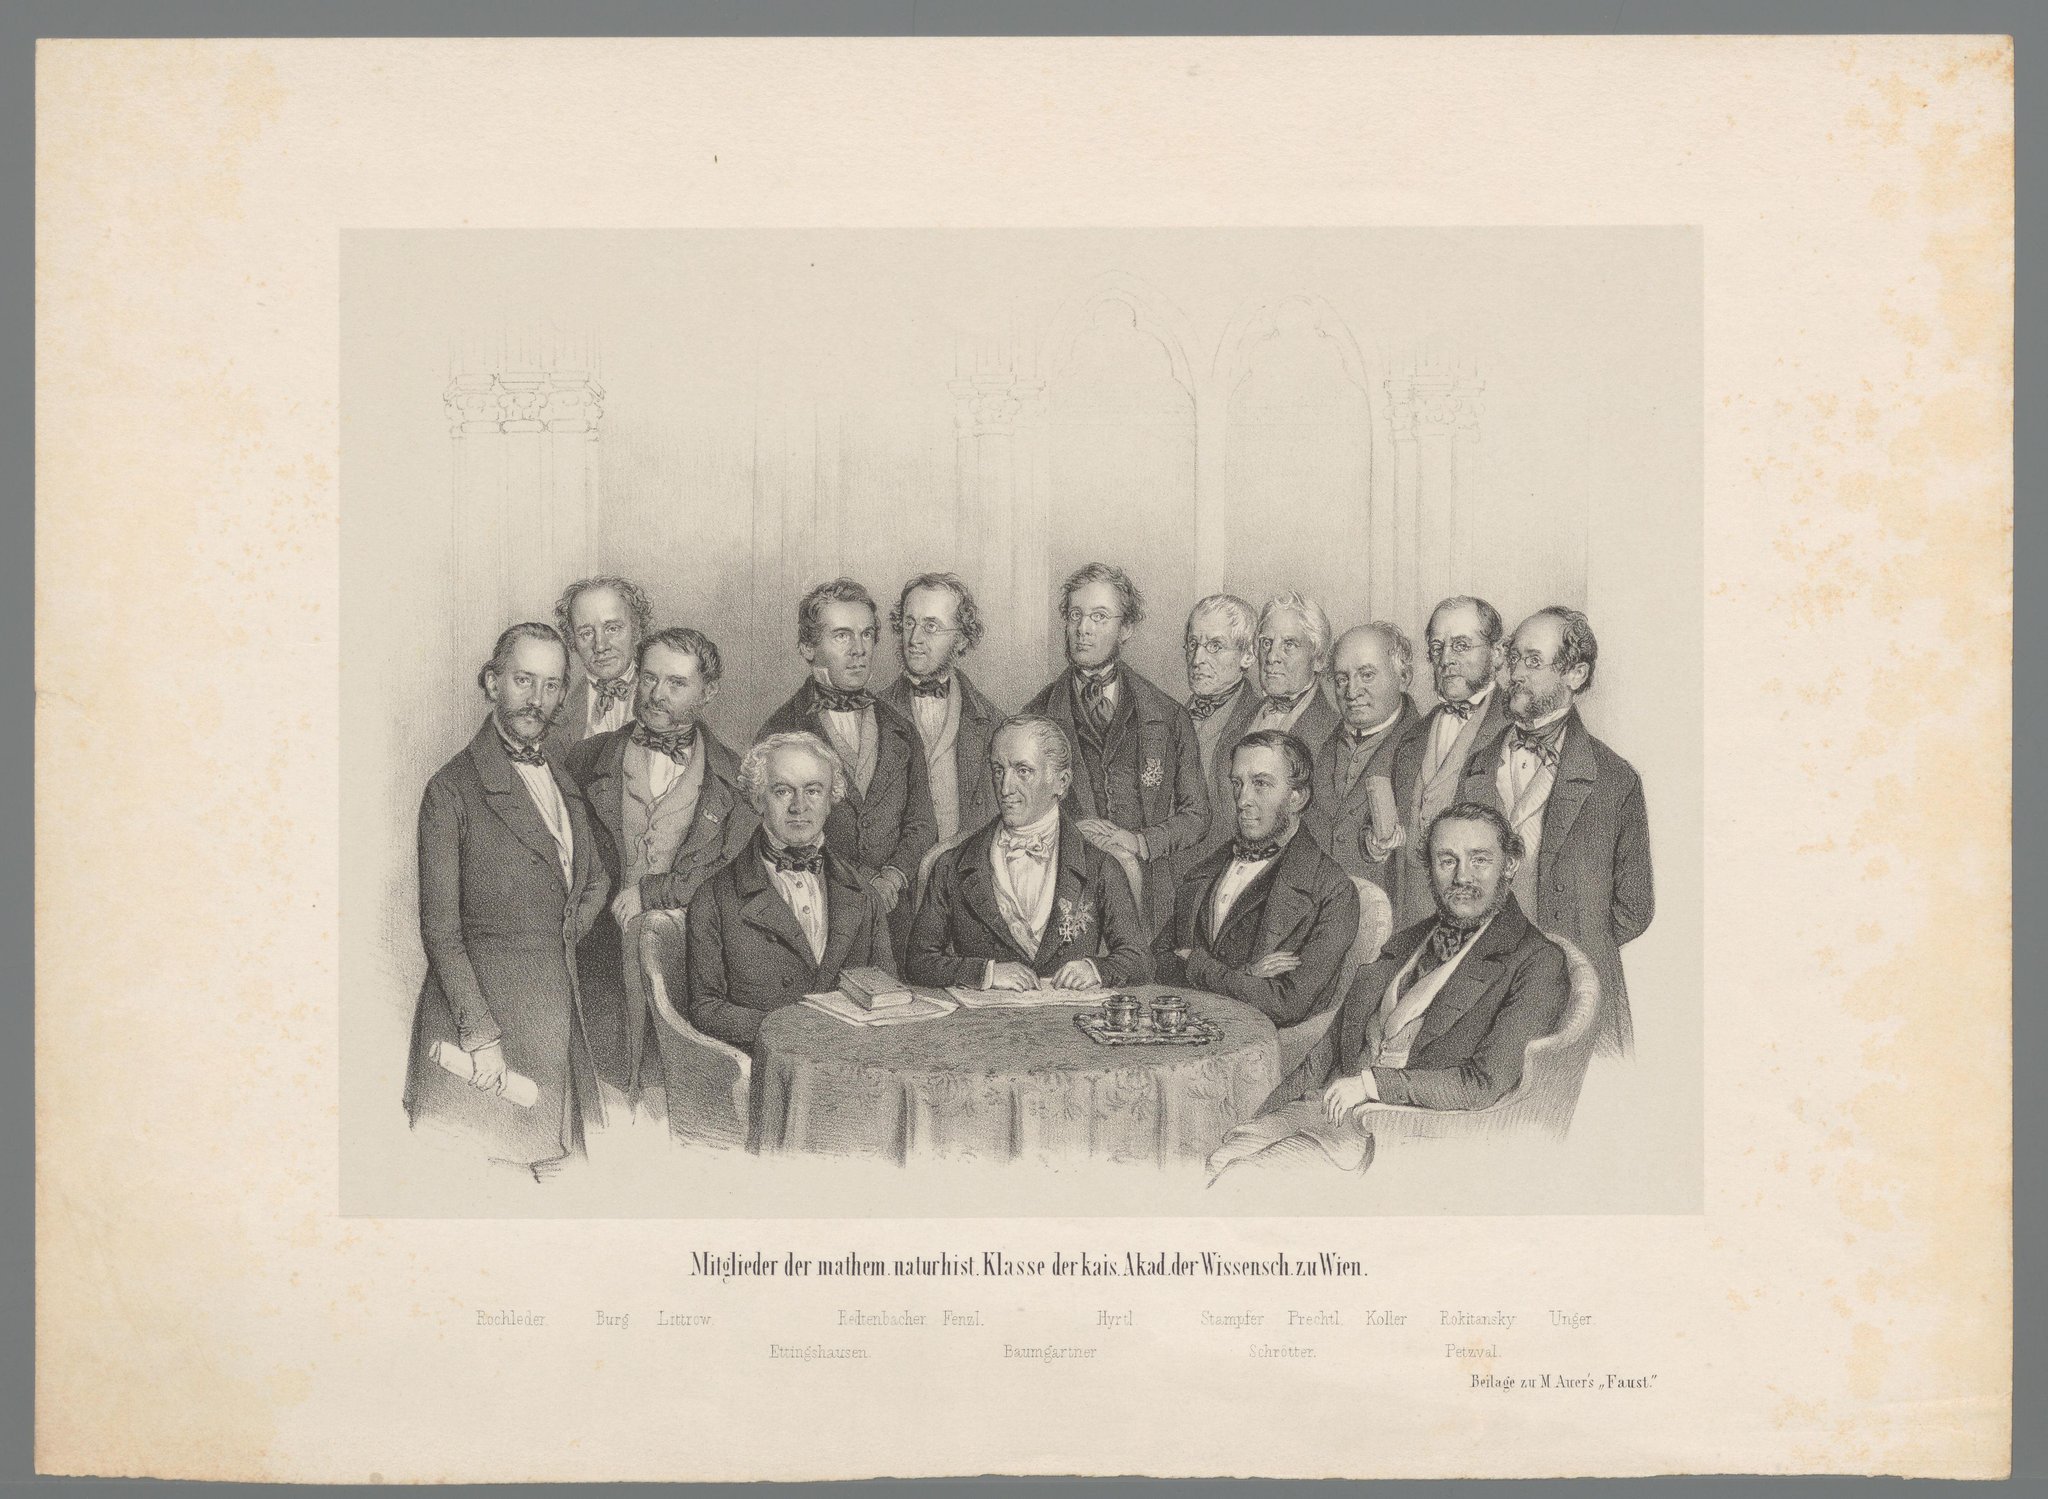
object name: print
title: Mitglieder der mathem. naturhist. Klasse der Kais. Akad. der Wissensch. zu Wien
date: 1854-1860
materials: paper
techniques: lithograph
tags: joseph petzval, vienna, venice, engineer, physicist, group of professors, historical persons, table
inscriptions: collector's mark: Lugt 2228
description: Portretten van: Friedrich Rochleder, Adam von Burg, Karl Ludwig von Littrow, Josef Redtenbacher, Eduard Fenzl, Josef Hyrtl, Simon Stampfer, Johann Joseph von Prechtl, Marian Wolfgang Koller, Carl von Rokitansky, Franz Unger, Andreas von Ettingshausen, Andreas von Baumgartner, Anton Schrötter von Kristelli en Joseph Petzval.